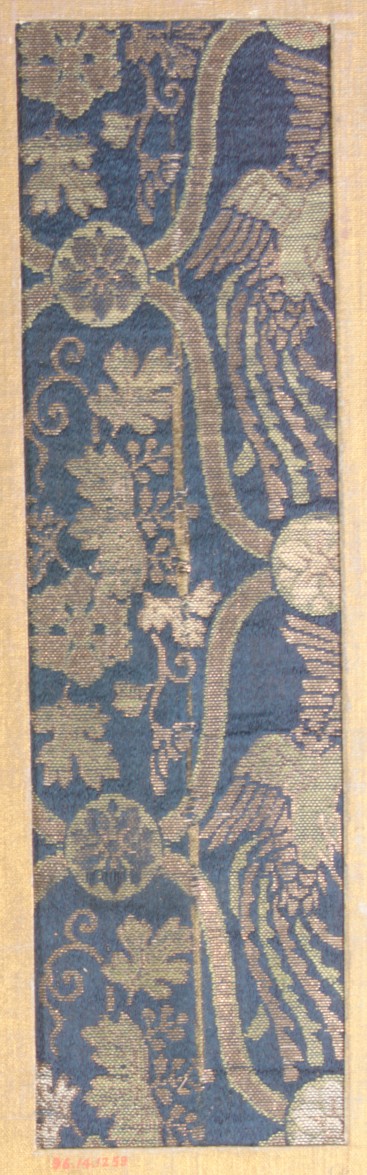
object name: piece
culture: japanese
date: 1701-1900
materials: silk